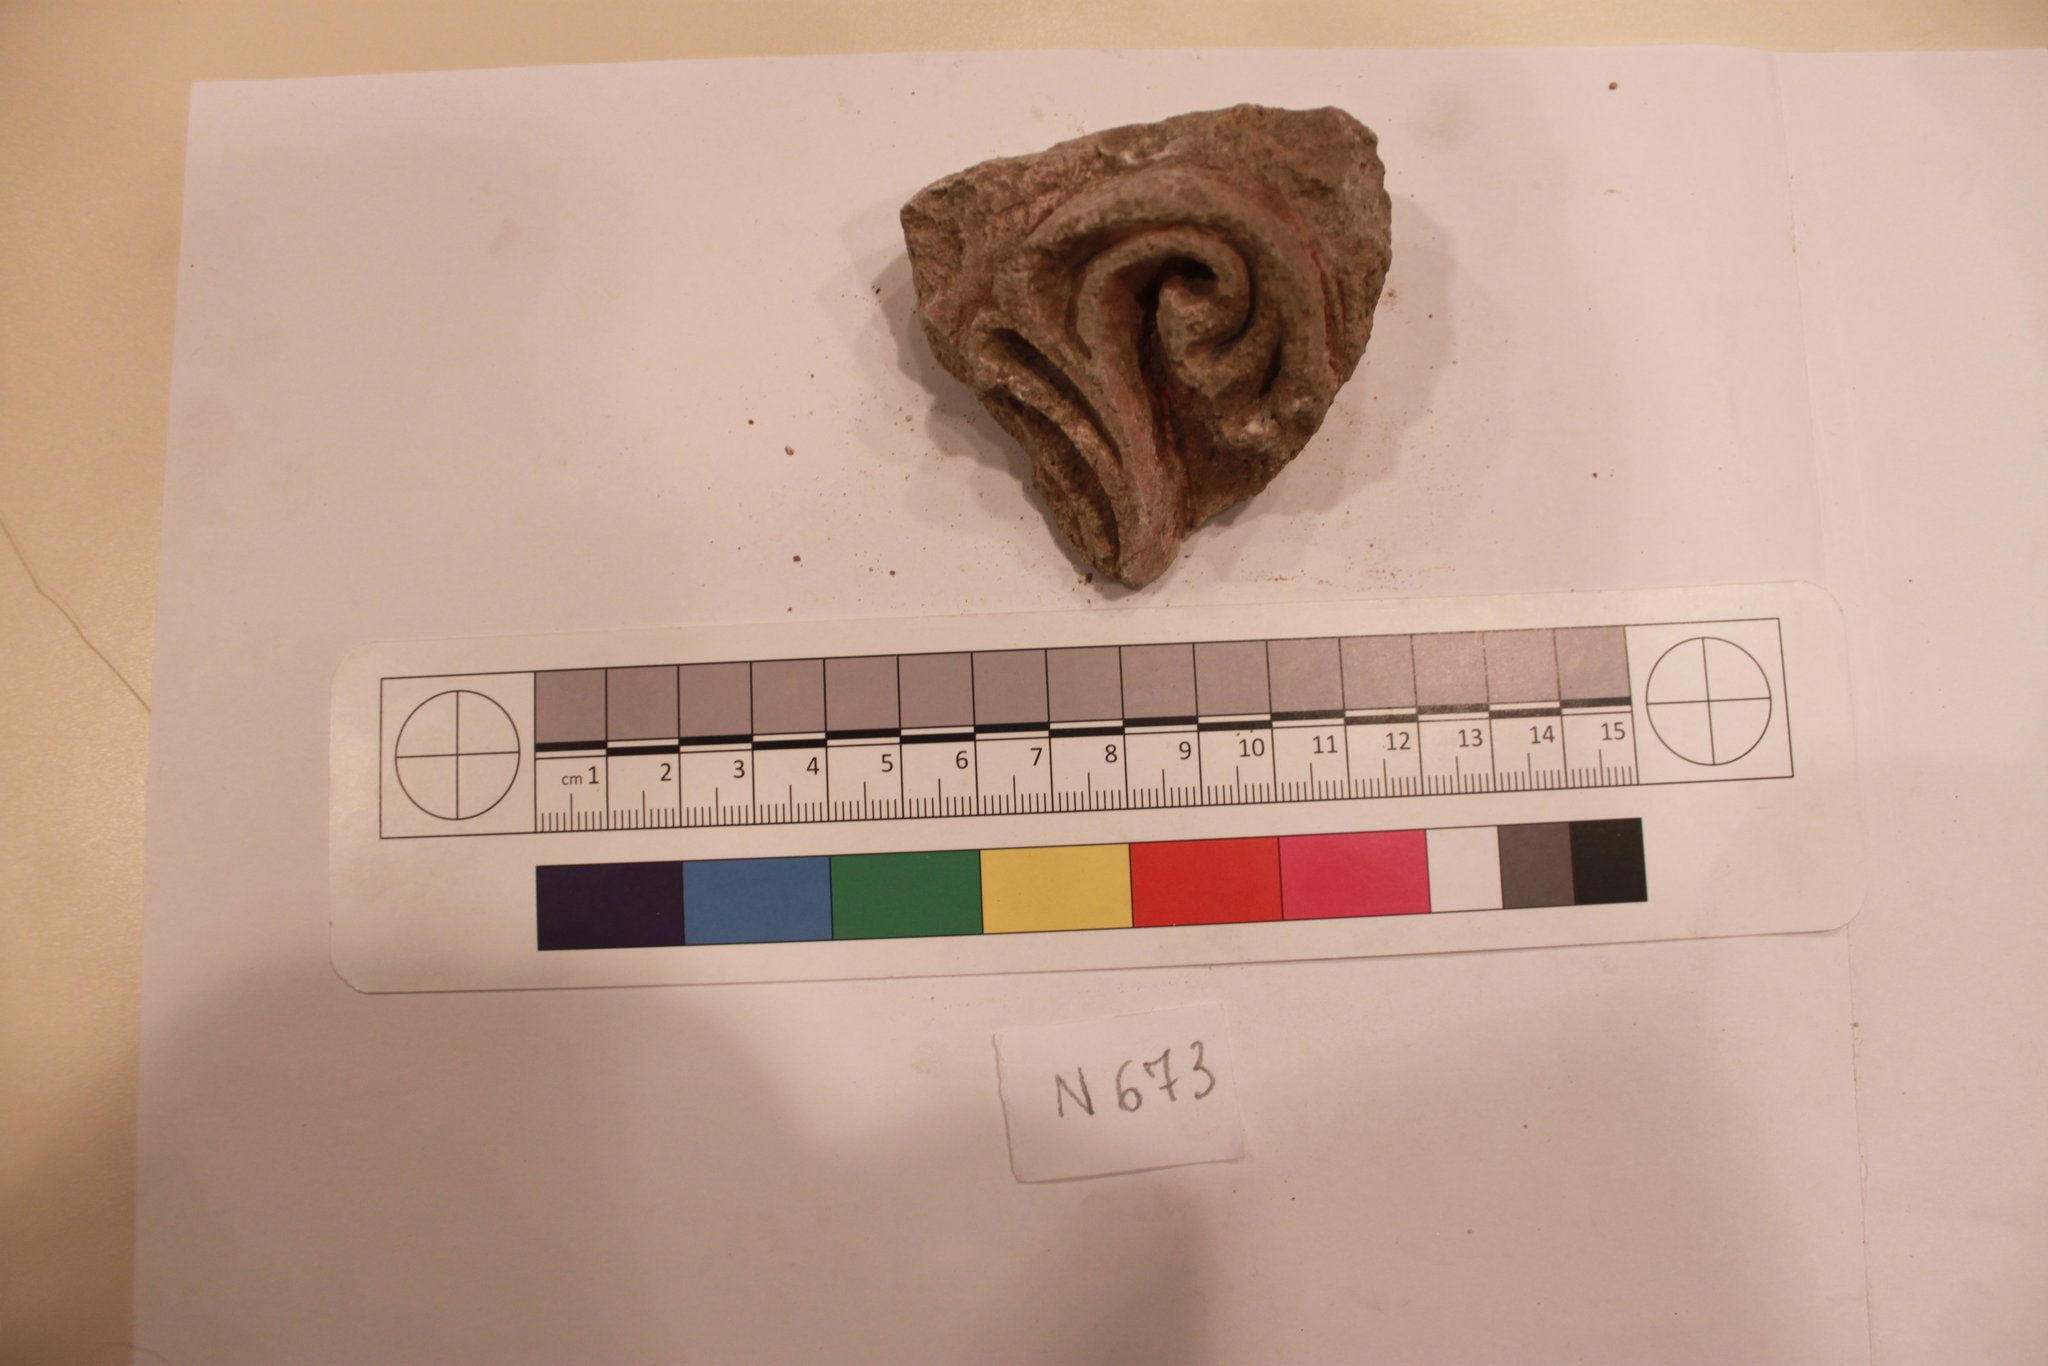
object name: fragment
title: Stucco Fragment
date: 701-1200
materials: plaster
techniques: carving, painting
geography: iran